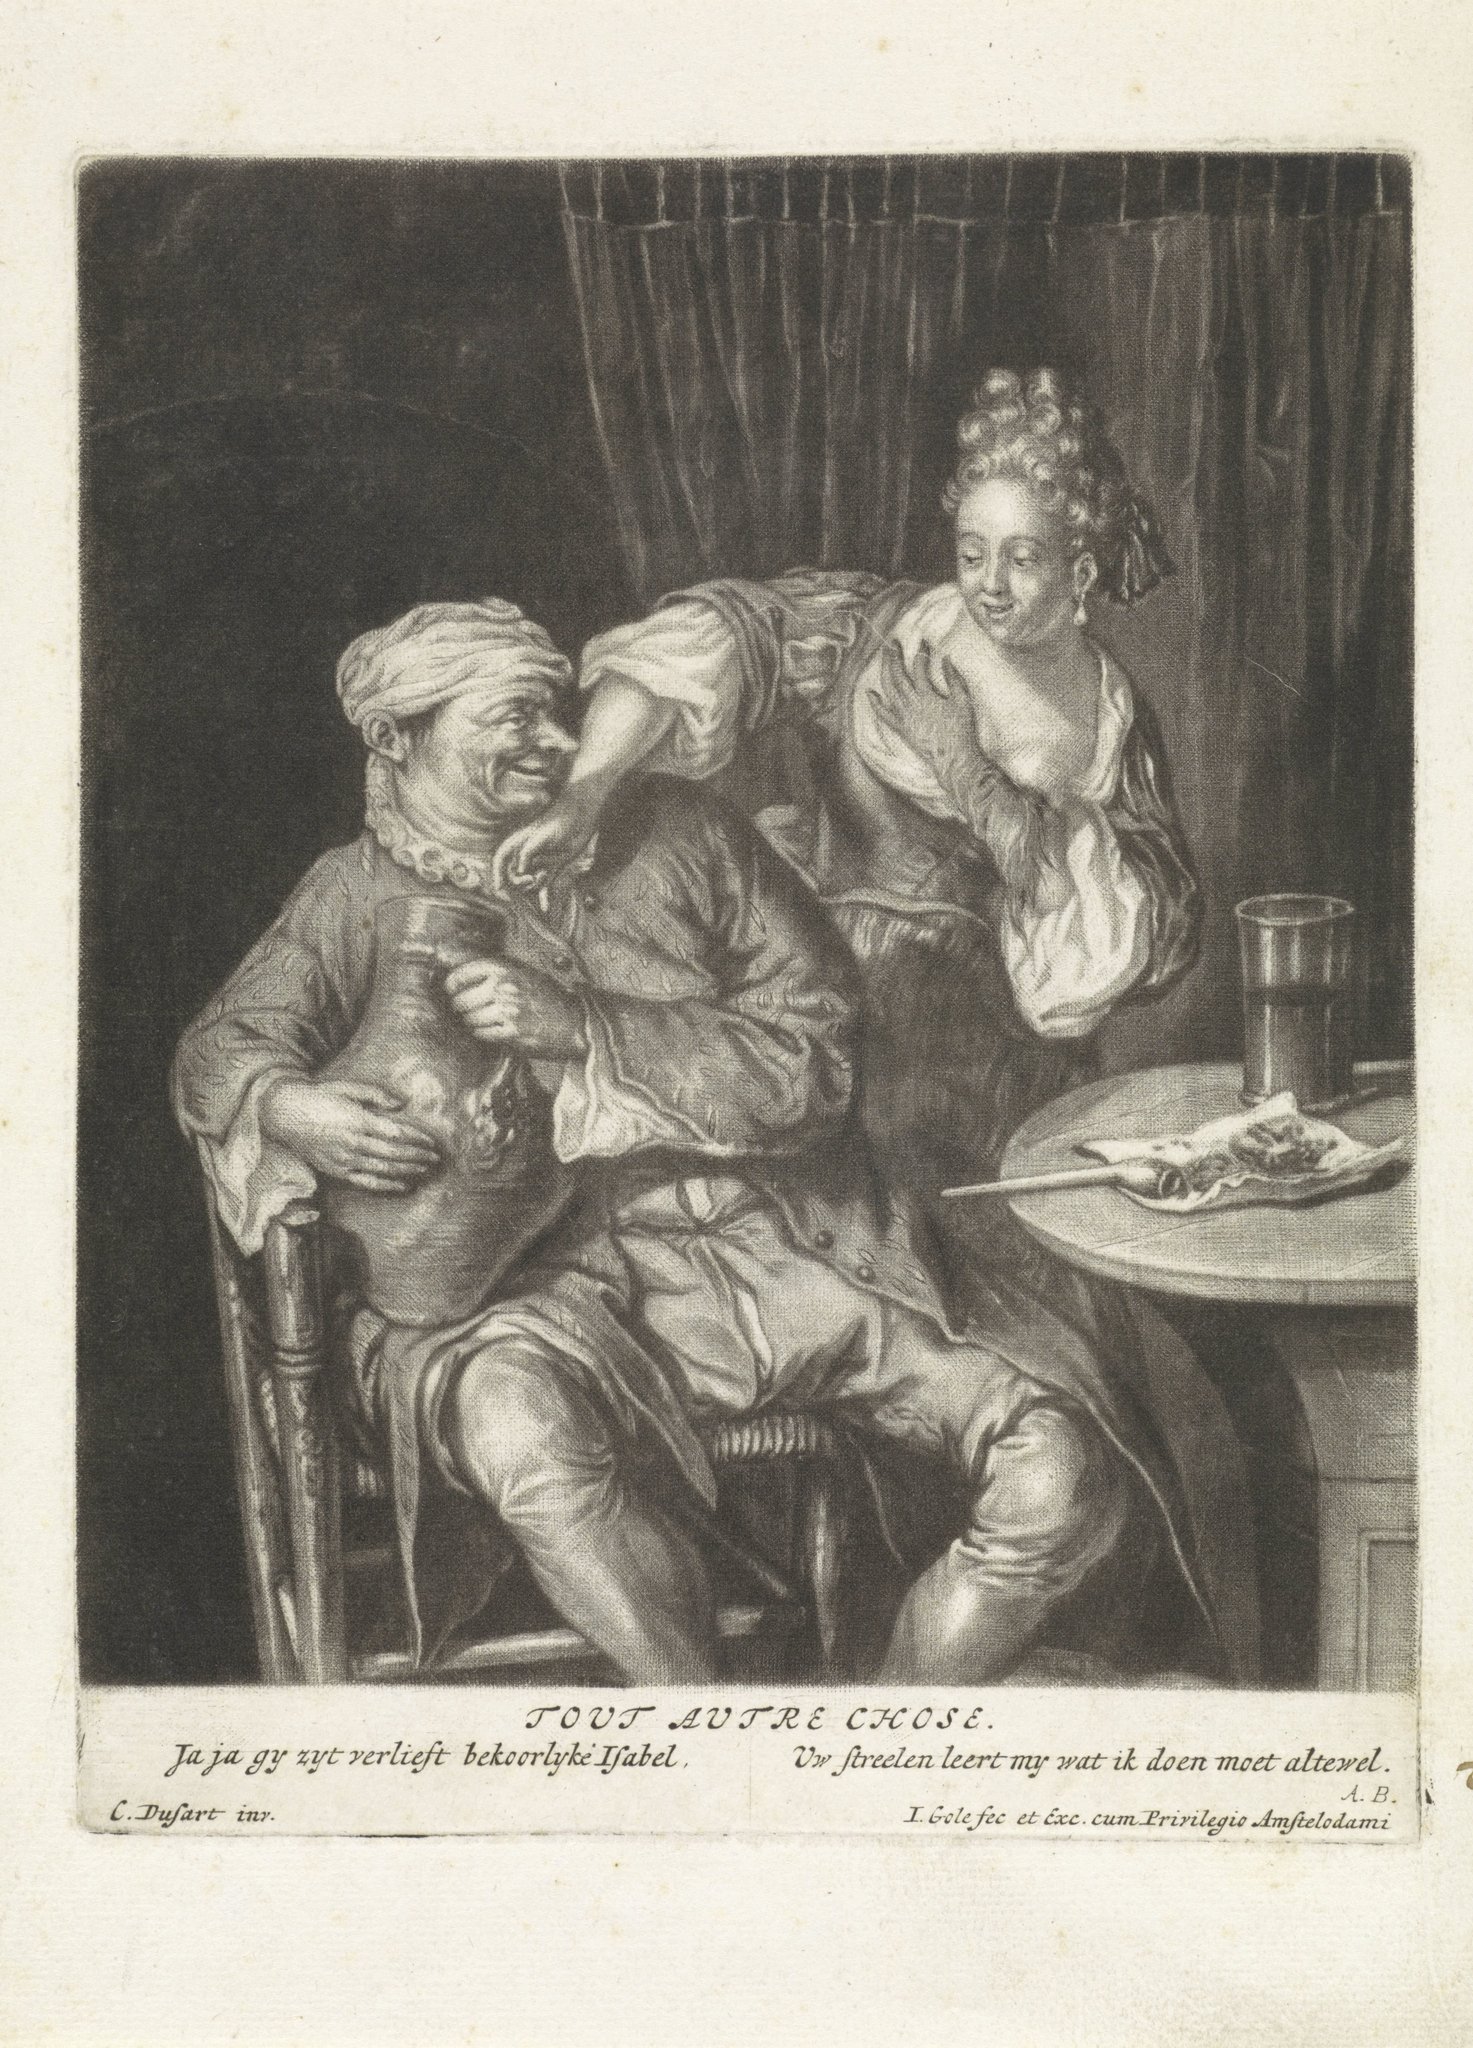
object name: print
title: Vrouw en man met een wijnkruik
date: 1670-1724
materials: paper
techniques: engraving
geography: amsterdam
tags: pipe ~ tobacco, jar, jug (used as drinking-vessel)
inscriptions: collector's mark: Lugt 2760, collector's mark: Lugt 2228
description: Een jonge vrouw reikt naar de wijnkruik die een man in zijn handen heeft. Op de tafel naast hen een pijp en een beker.